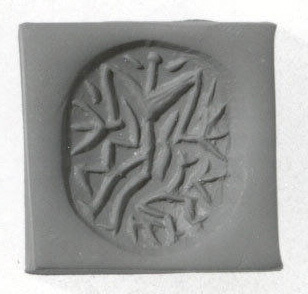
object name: stamp seal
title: Carinated hemispheroid seal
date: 4000-3500 BCE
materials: mineral, stone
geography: northern mesopotamia, syria or southwestern iran